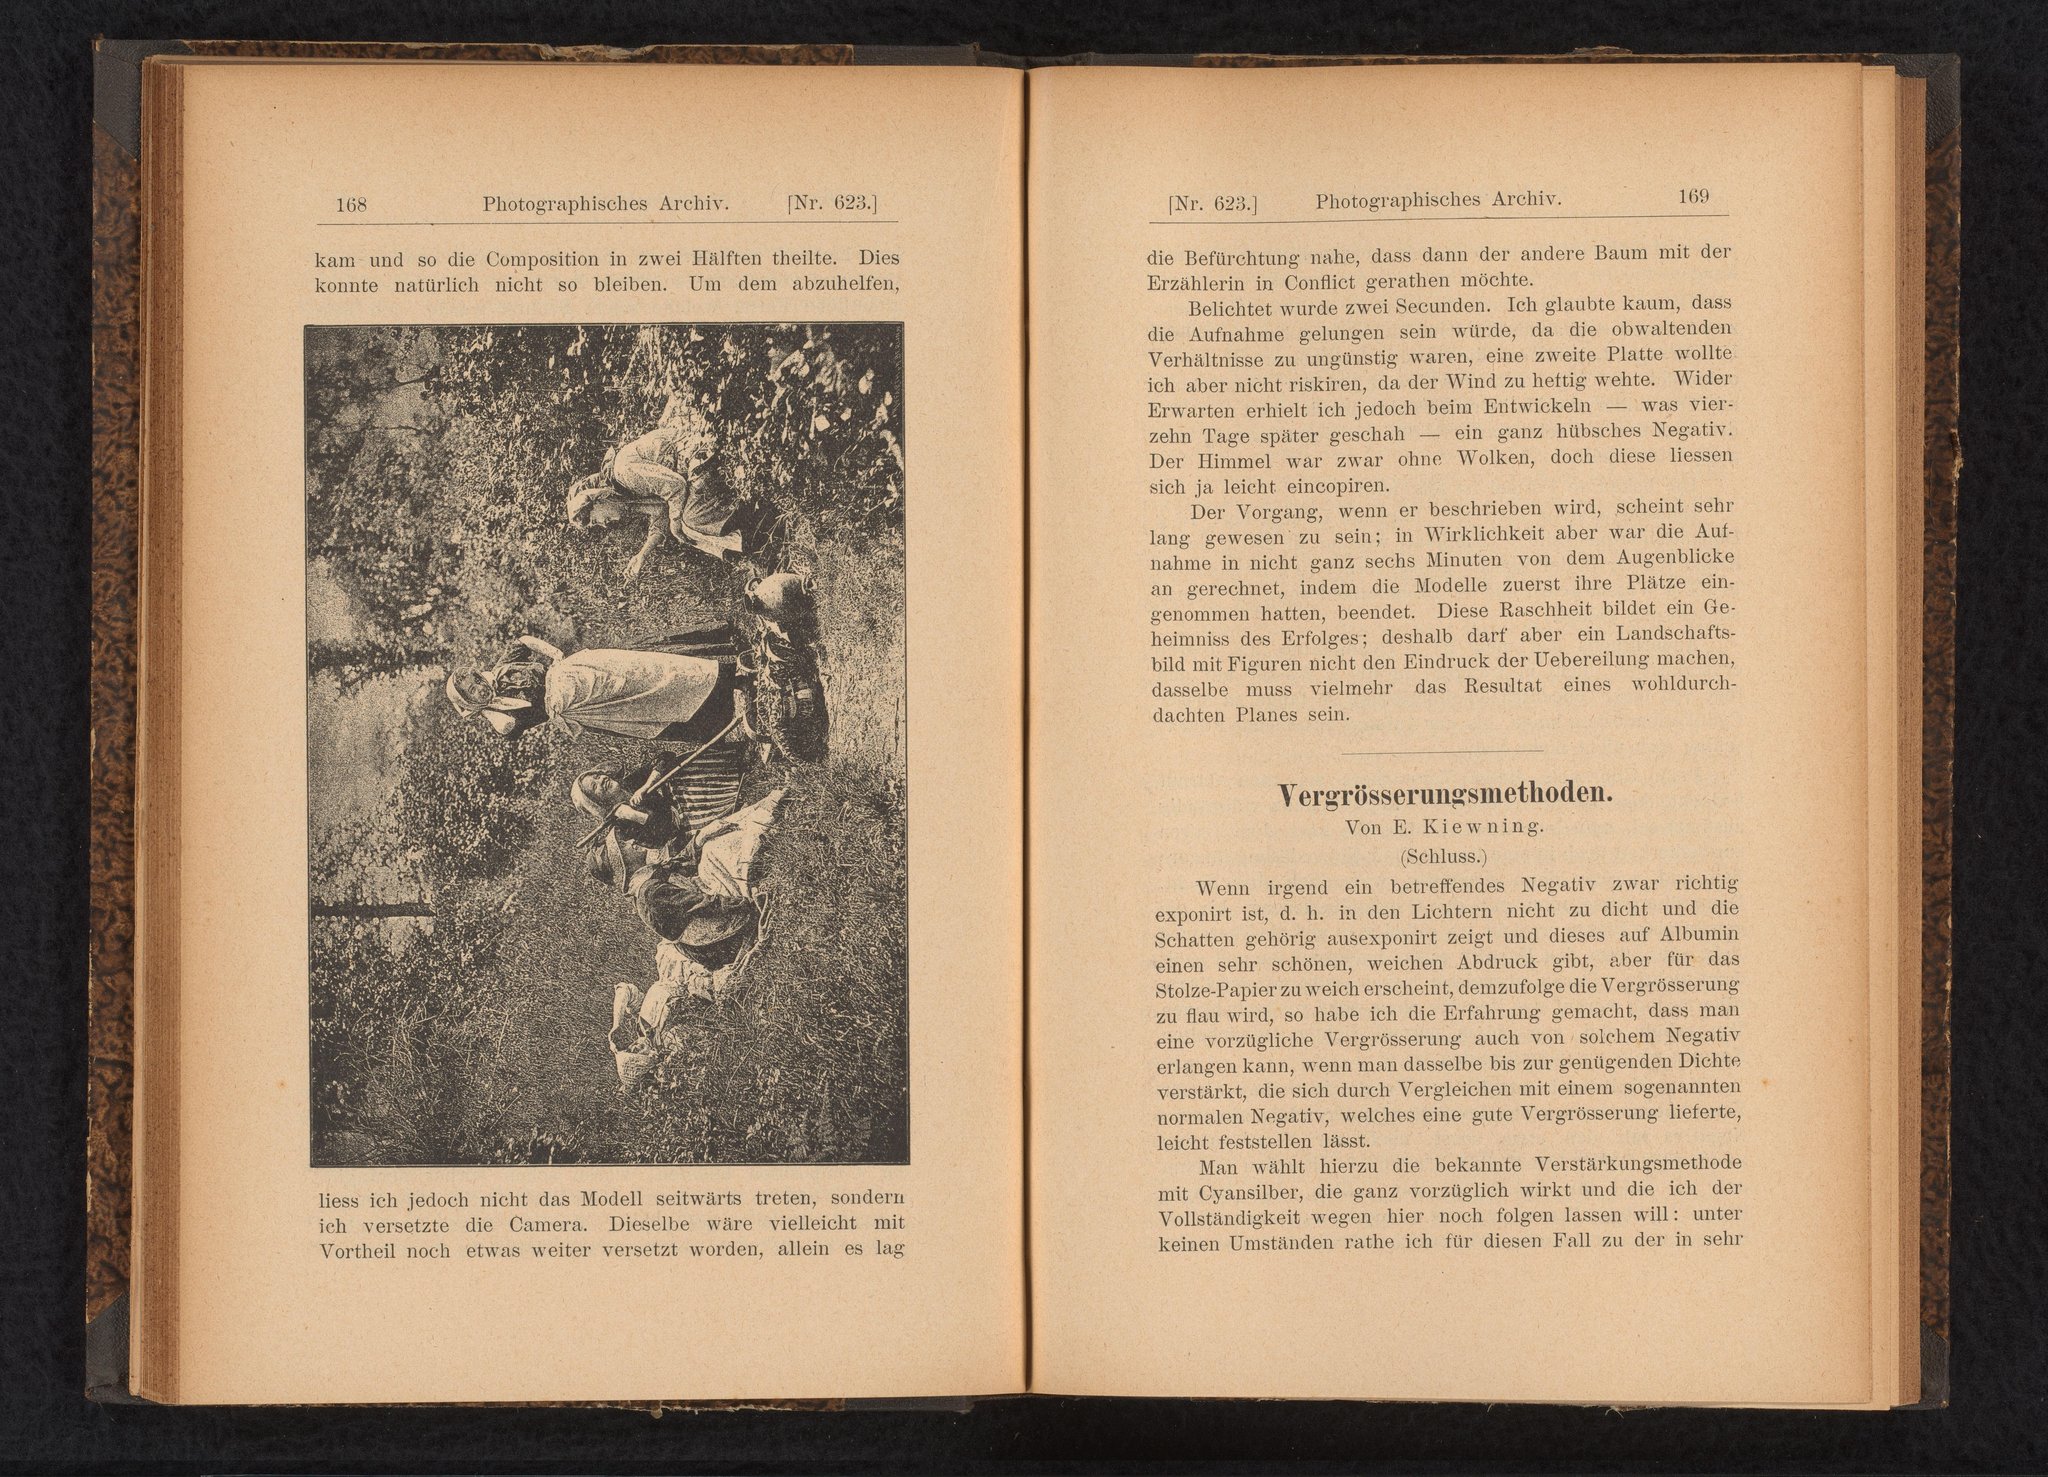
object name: page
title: Vier vrouwen met manden in een veld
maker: Anonymous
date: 1884-1889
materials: paper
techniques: photolithography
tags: container made of plant material other than wood: basket, fruit harvest